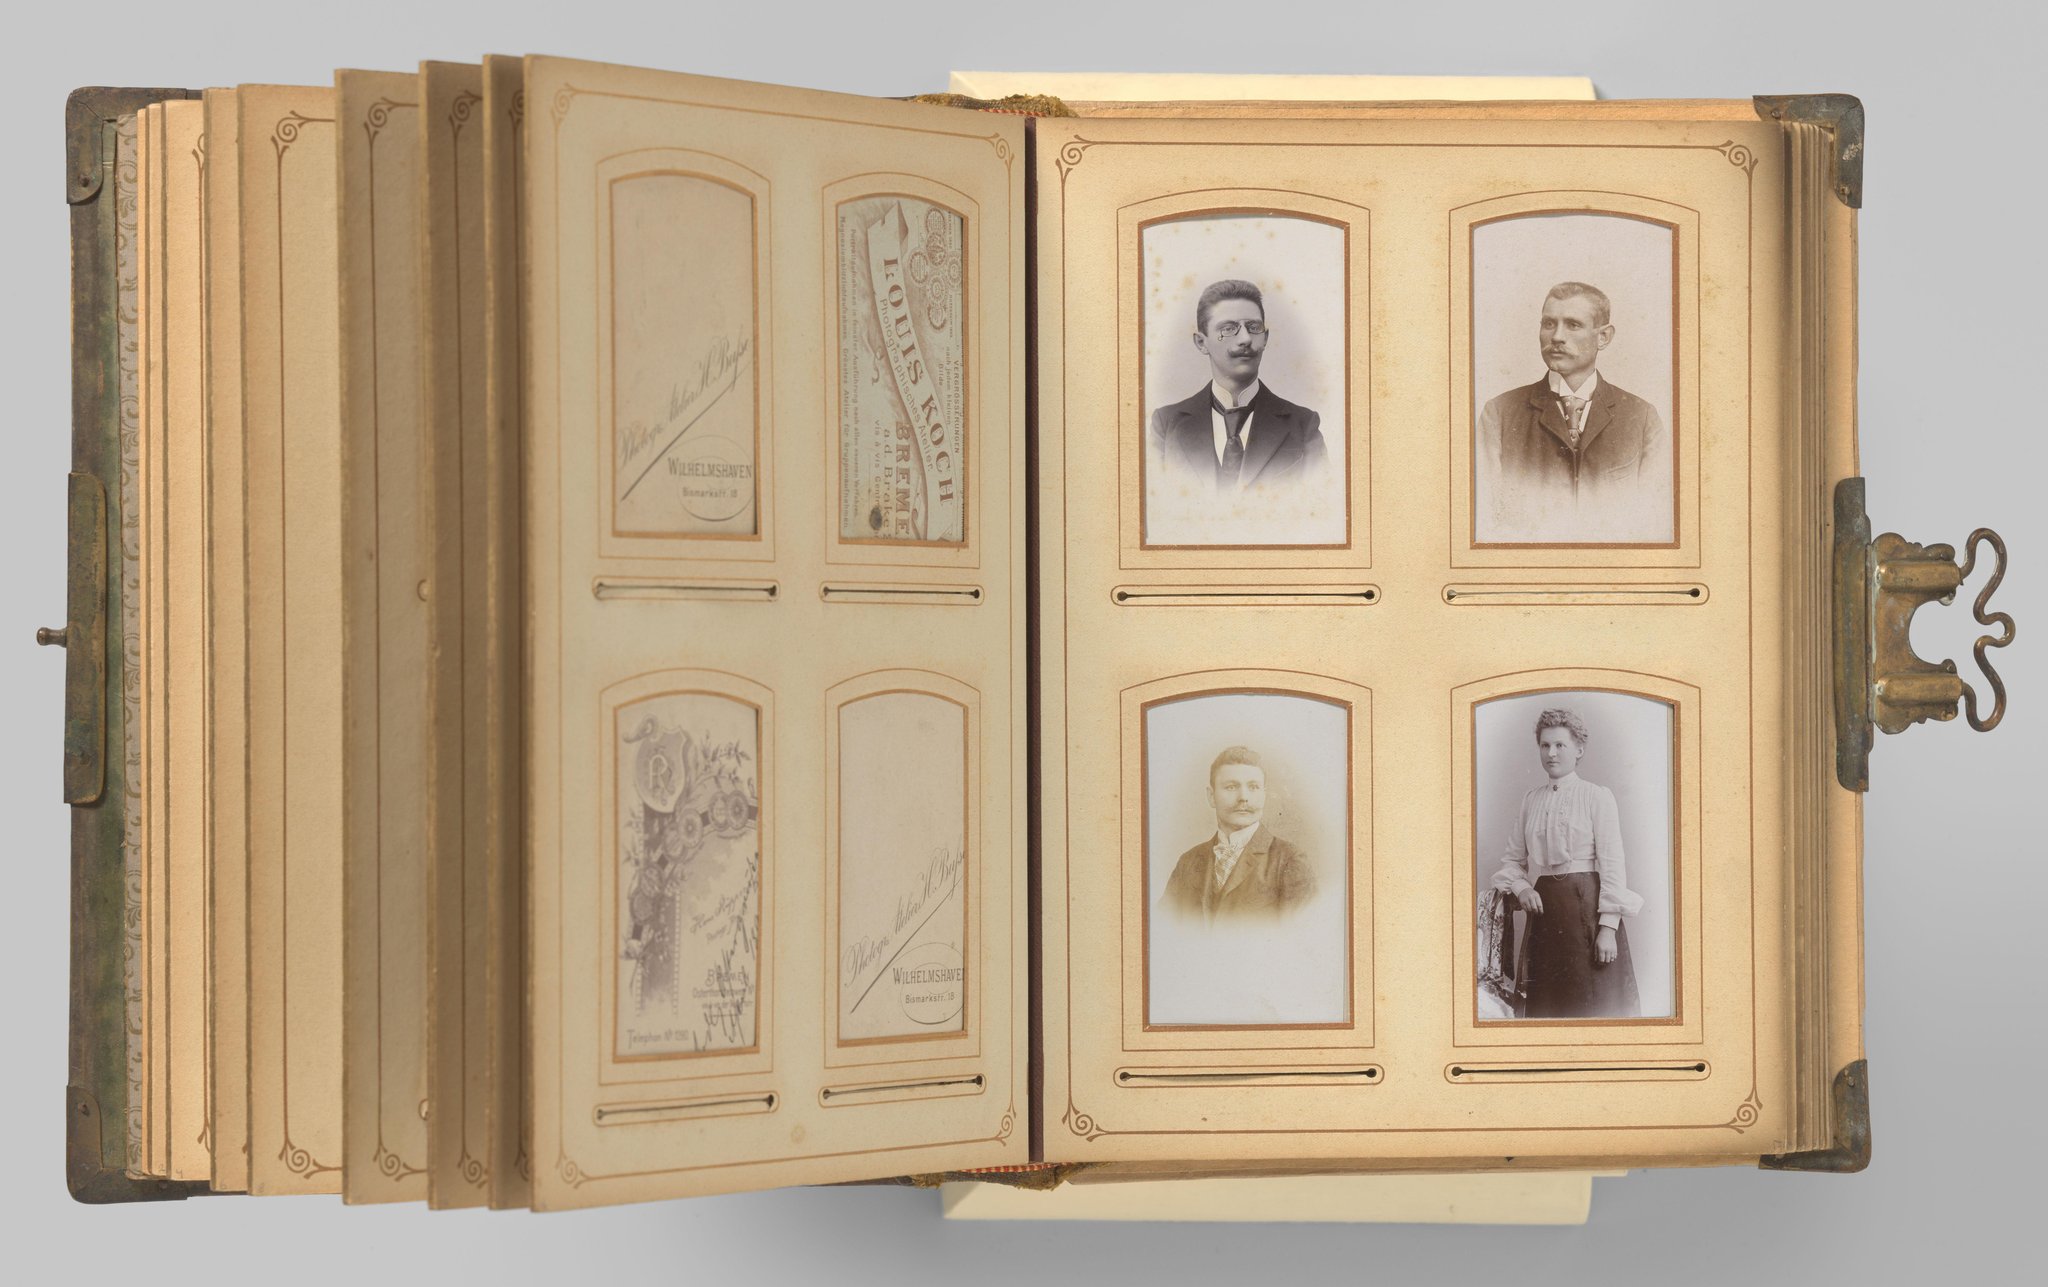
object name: photograph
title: Portret van een man met snor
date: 1880-1920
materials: cardboard, photographic support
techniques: collodion silver print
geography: berlin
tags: moustache, historical persons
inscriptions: inscription: ‘No... [...]/ A. Jandorf & Co./ BERLIN/ C.Spittelmarkt 16/17// S.W.Leipzigerstr. 64./ S.W.Bellealliancestr. 1/2./ am Blücherplatz.’